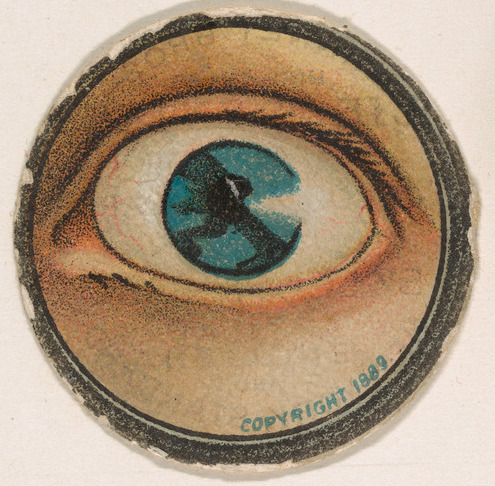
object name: print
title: Monocle and Eye (blue), from Jocular Ocular series (N221) issued by Kinney Bros.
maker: kinney brothers tobacco company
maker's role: publisher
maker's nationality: american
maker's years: 1869-2011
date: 1889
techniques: color lithograph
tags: eyes